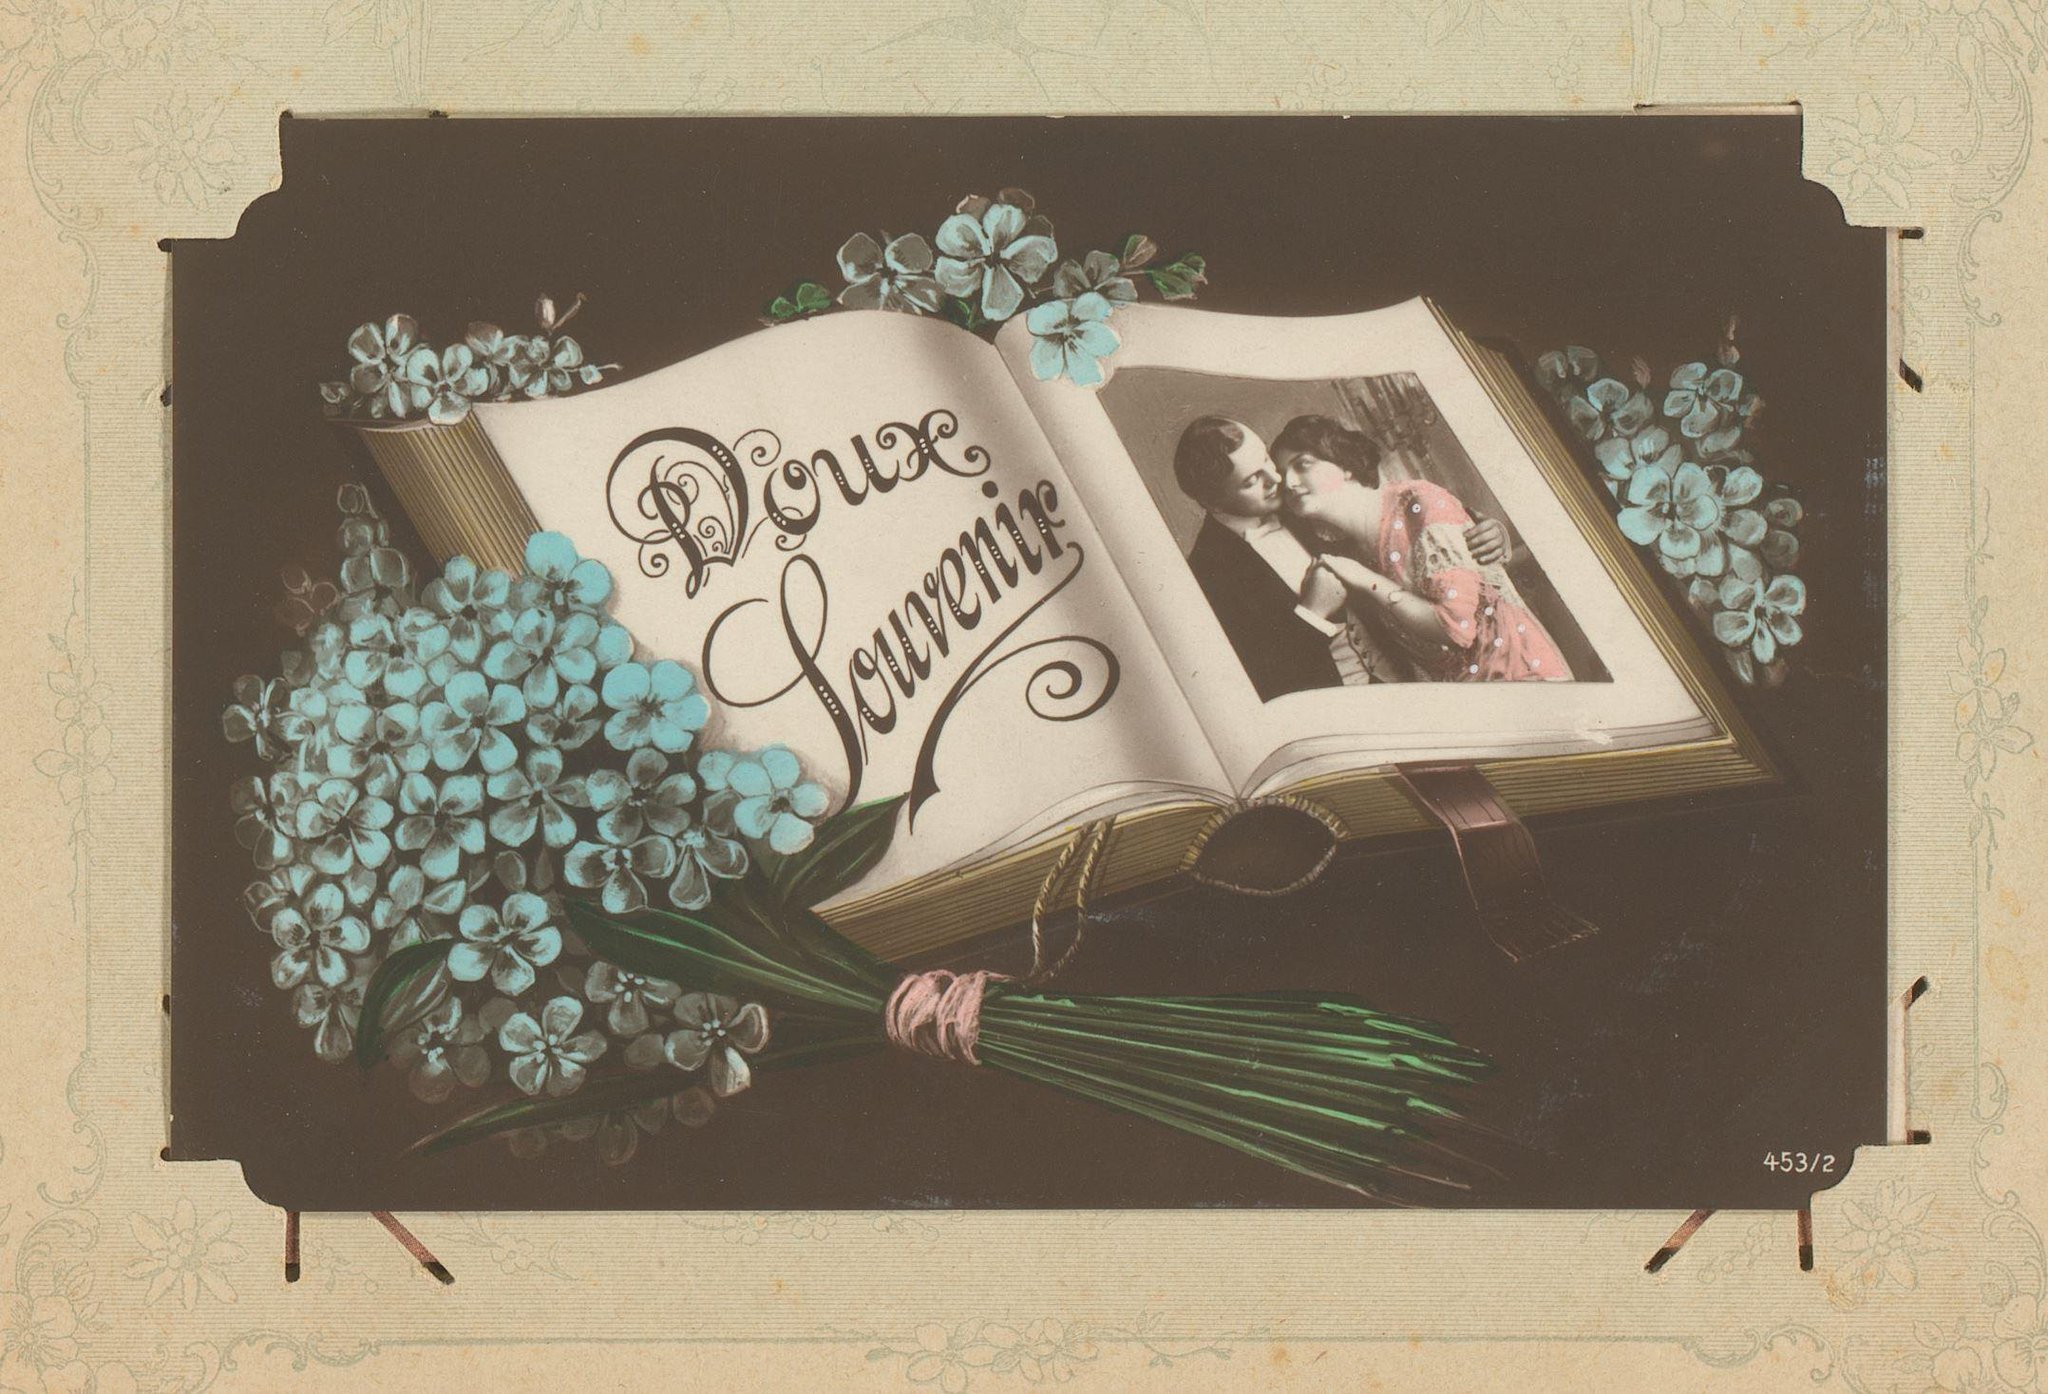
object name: album leaf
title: Fotoalbum met bloemen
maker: Anonymous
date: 1900-1950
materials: photographic support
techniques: gelatin silver print, hand coloring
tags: flowers, photograph